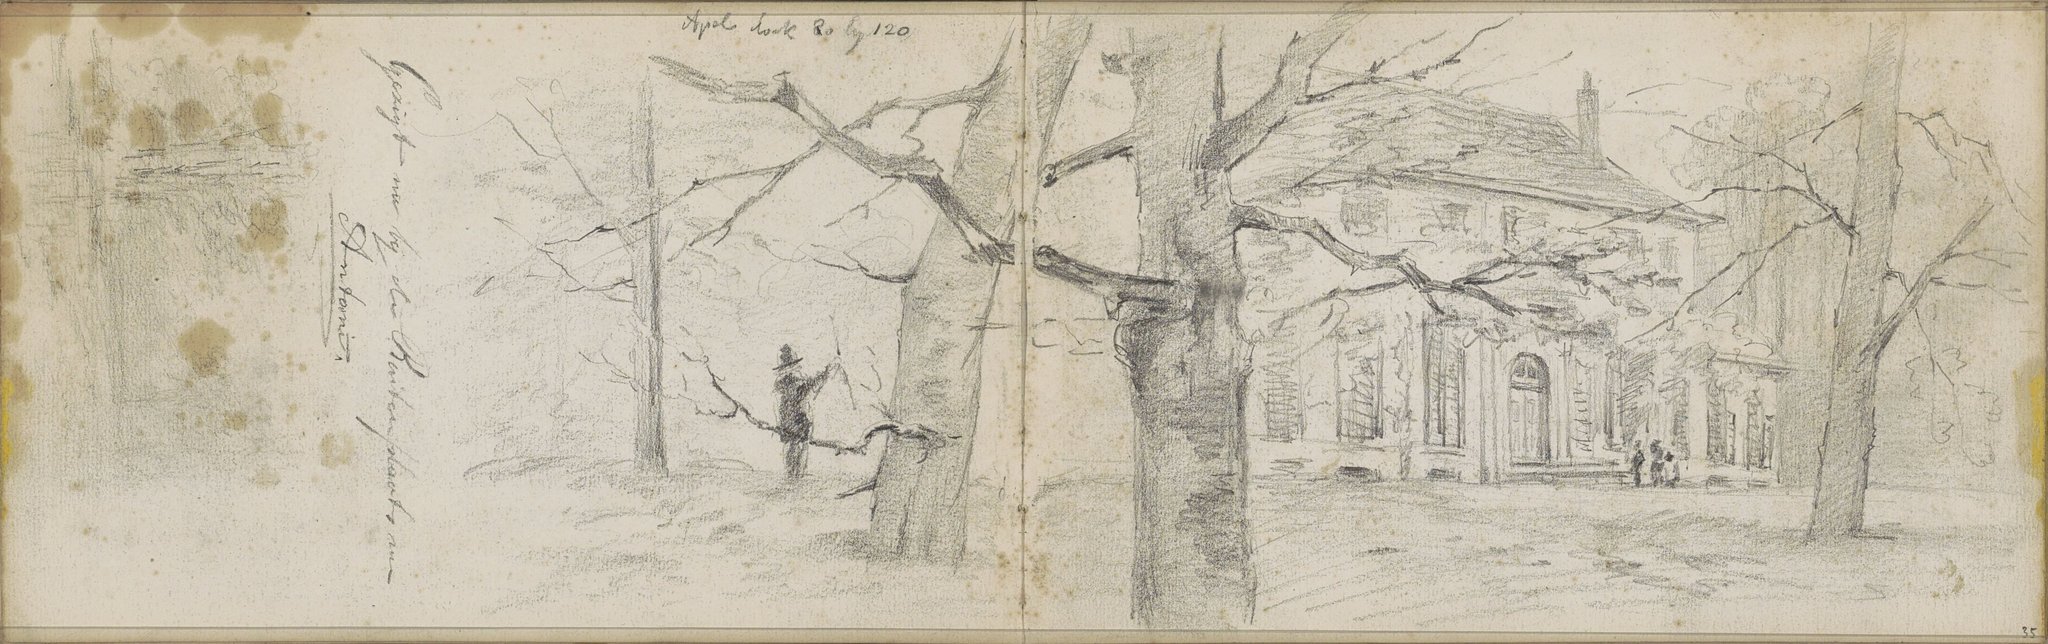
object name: sketchbook leaf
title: Buitenplaats van Antoni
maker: willem cornelis rip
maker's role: draughtsman, painter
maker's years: 1856-1922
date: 1876-1877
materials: paper, pencil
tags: landscapes with waters, waterscapes, seascapes (in the temperate zone), country-house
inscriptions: annotation: ‘Gezigt na bij de Buitenplaats van/ Antoni./ Apol [...] 30 bij 120’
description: Tevens een studie van een landschap met water nabij de buitenplaats. Blad 34 verso en 35 recto uit een schetsboek met 41 bladen.